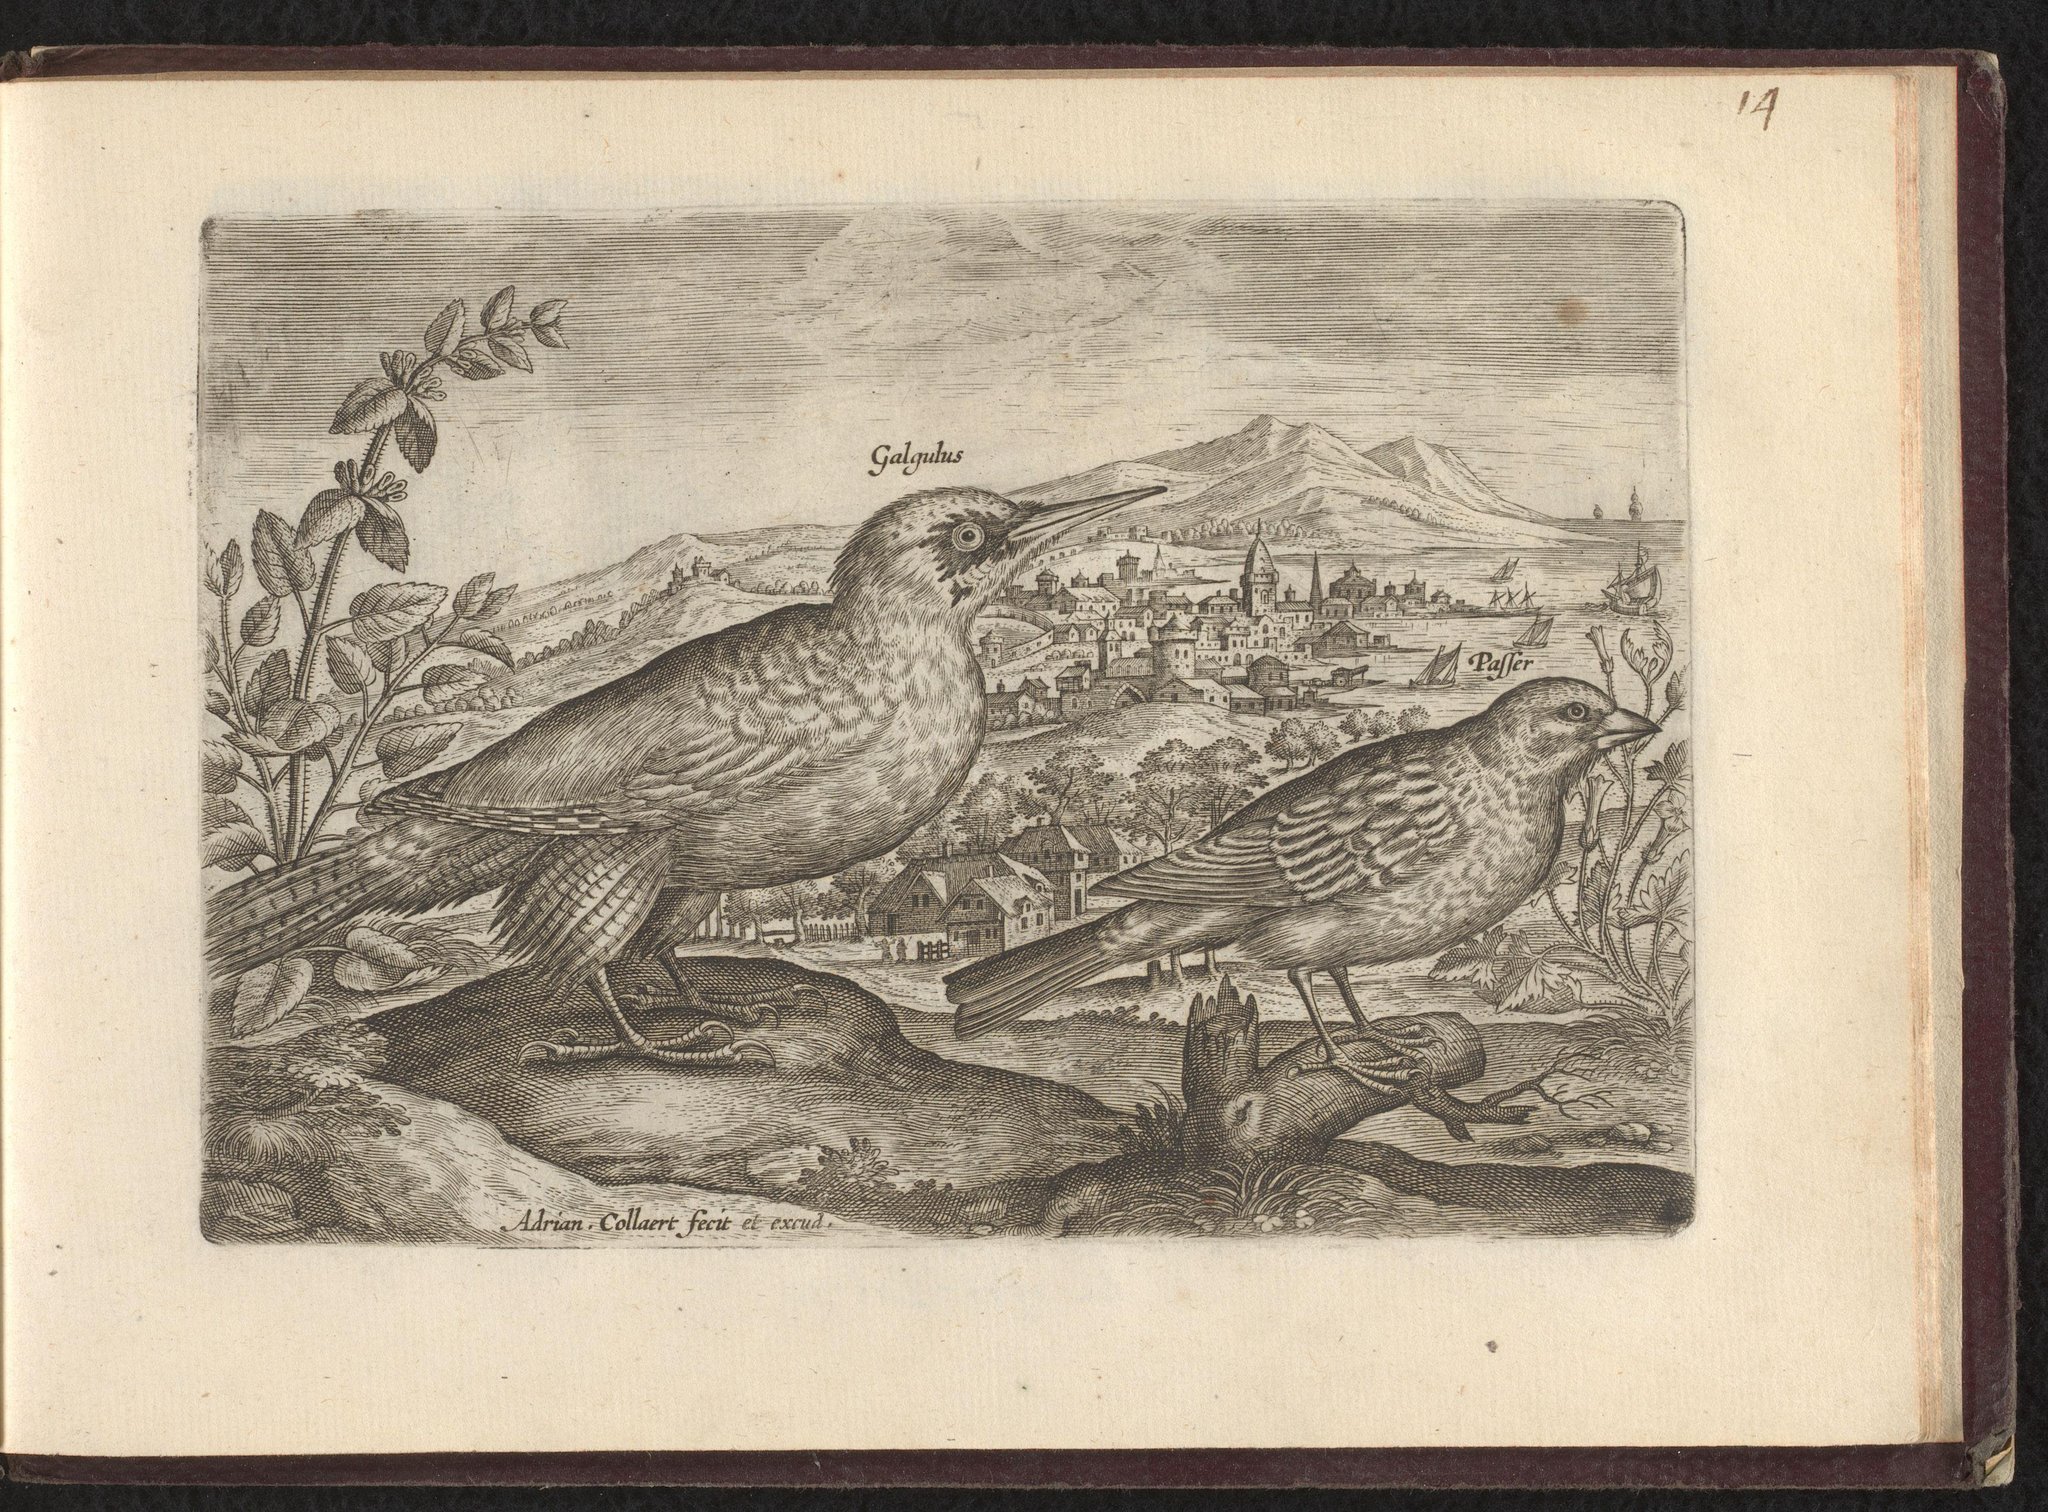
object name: print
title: Avium Vivae Icones in aes incisae & edita ab Adriano Collardo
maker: adriaen collaert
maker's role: draughtsman, print maker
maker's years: 1560-1618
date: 1600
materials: paper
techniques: engraving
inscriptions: signature and address: ‘Adrian Collaert fecit et excud.’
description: Een mus en een Galgulus zittend voor een heuvellandschap.